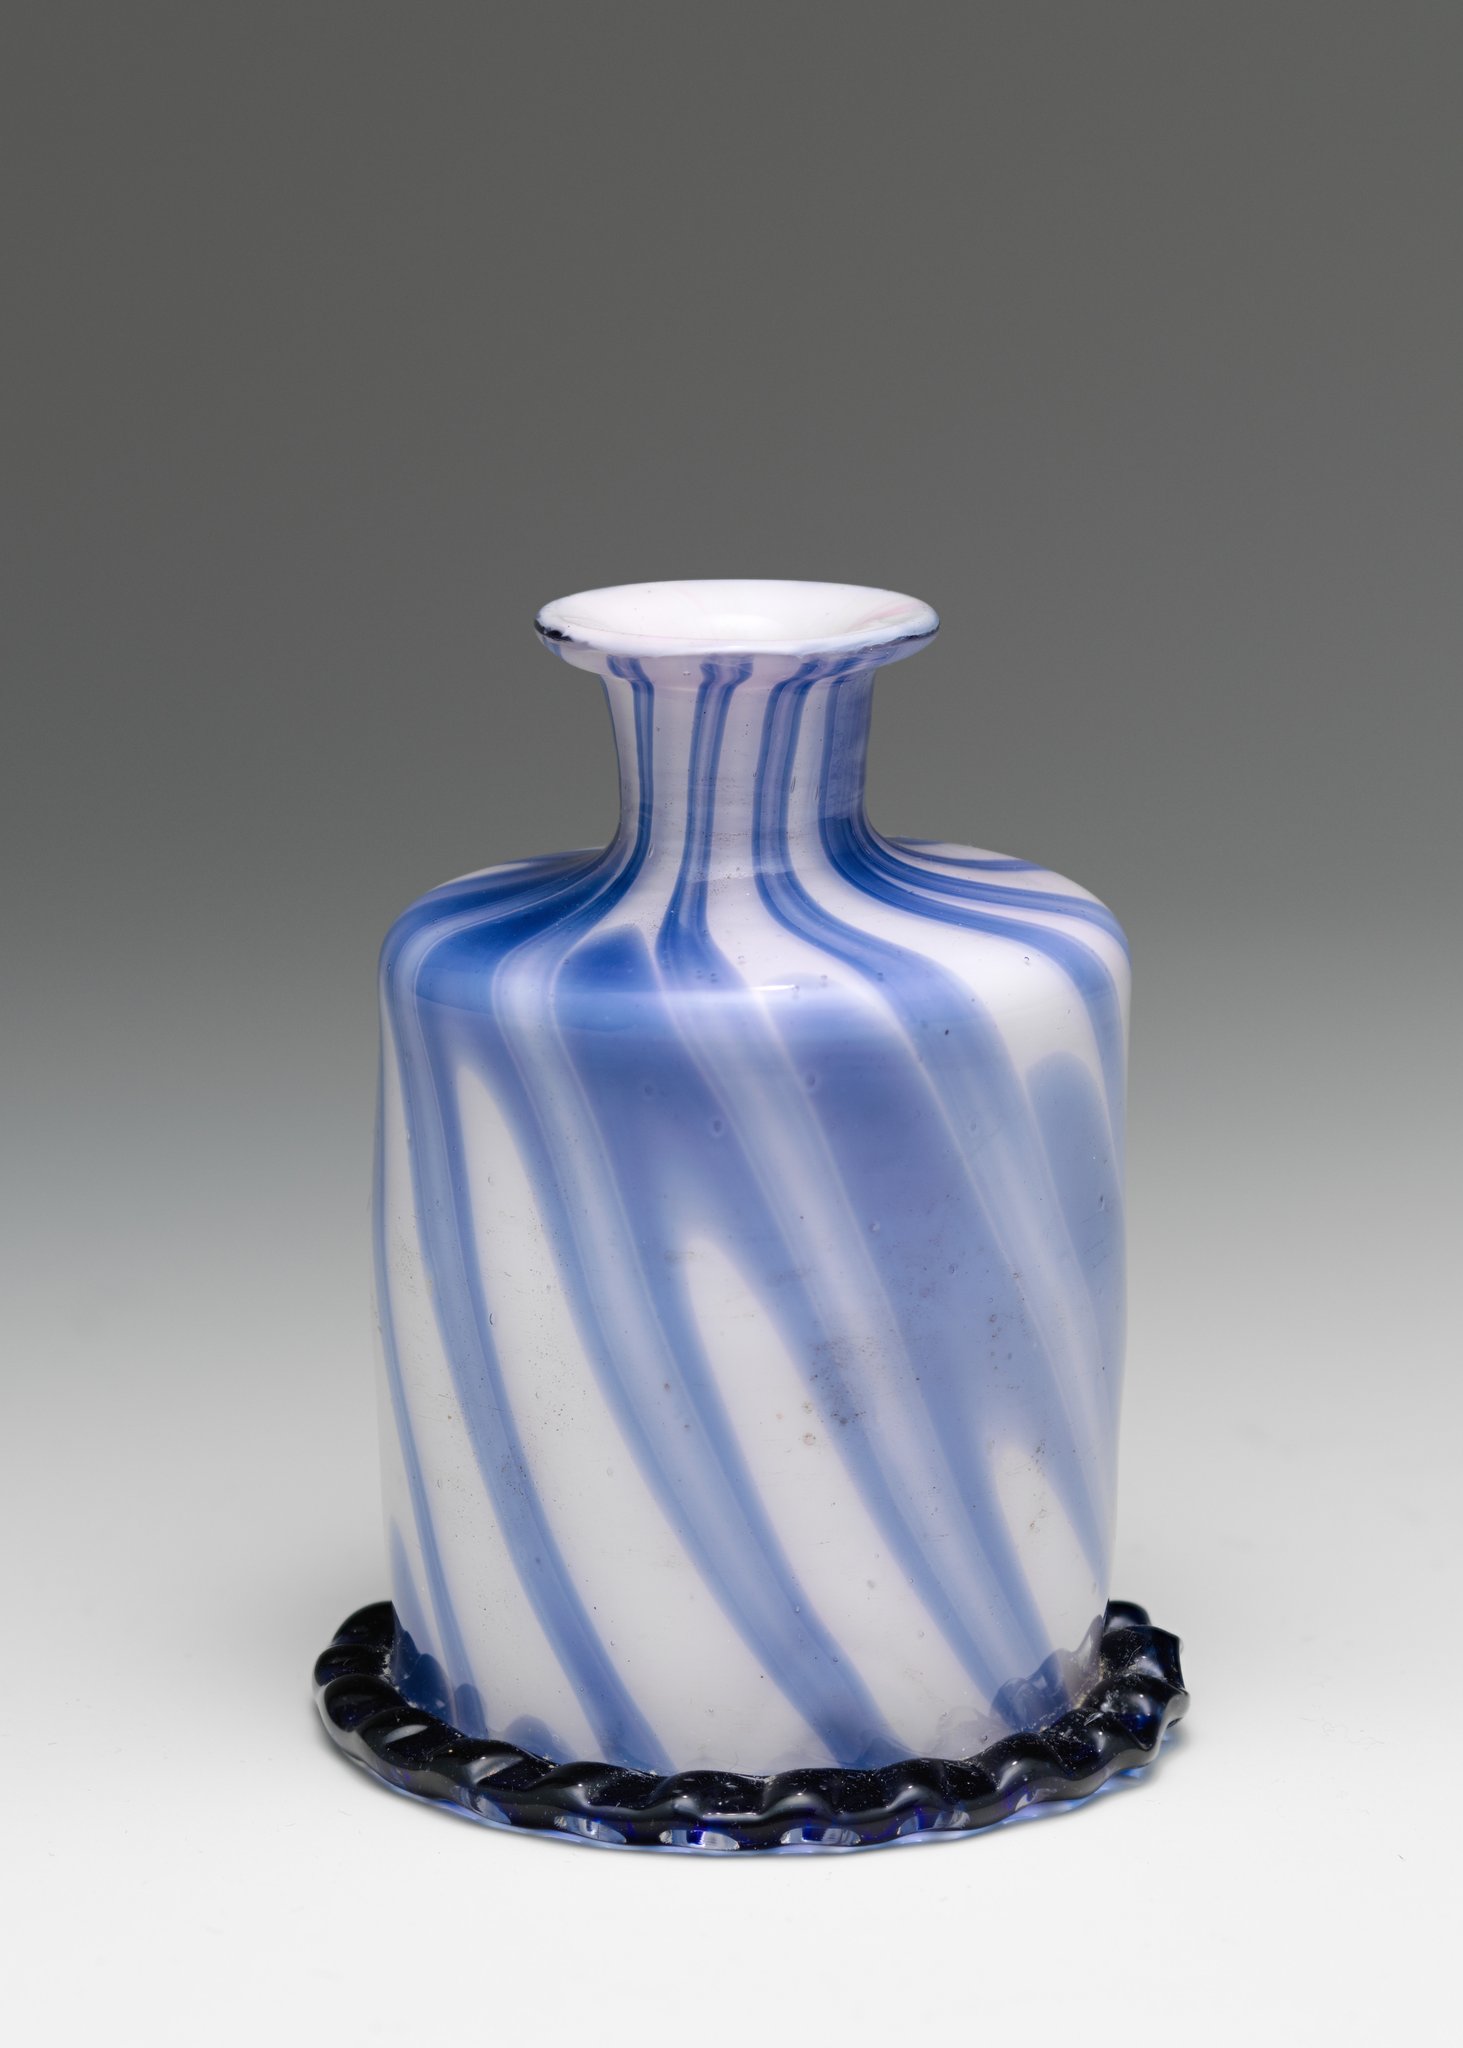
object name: bottle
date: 1701-1800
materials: glass